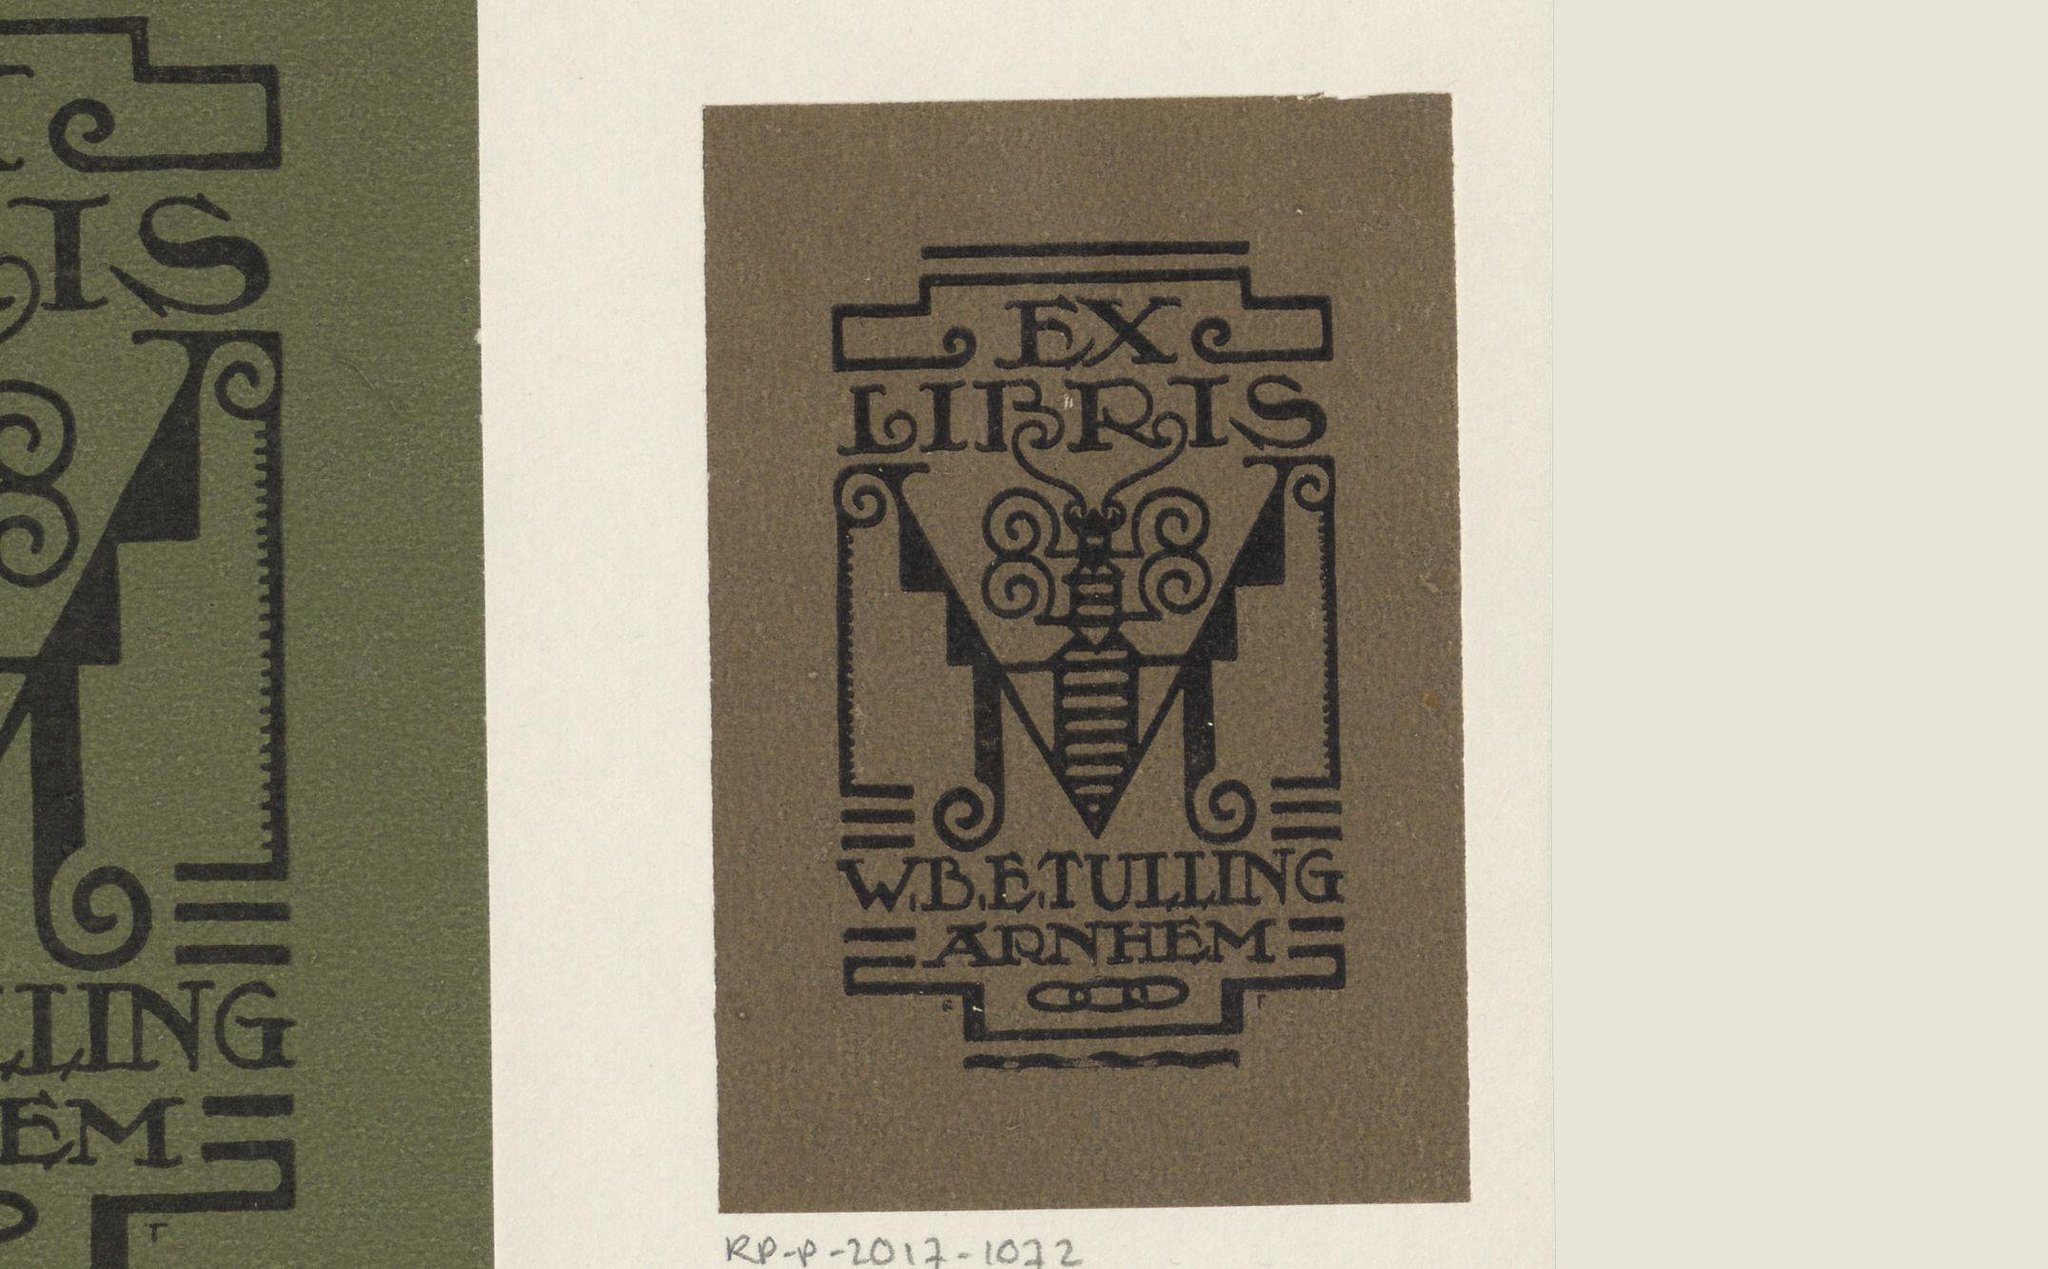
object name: bookplate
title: Ex libris van W.B.E. Tulling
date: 1926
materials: paper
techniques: printing block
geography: netherlands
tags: insects: ant